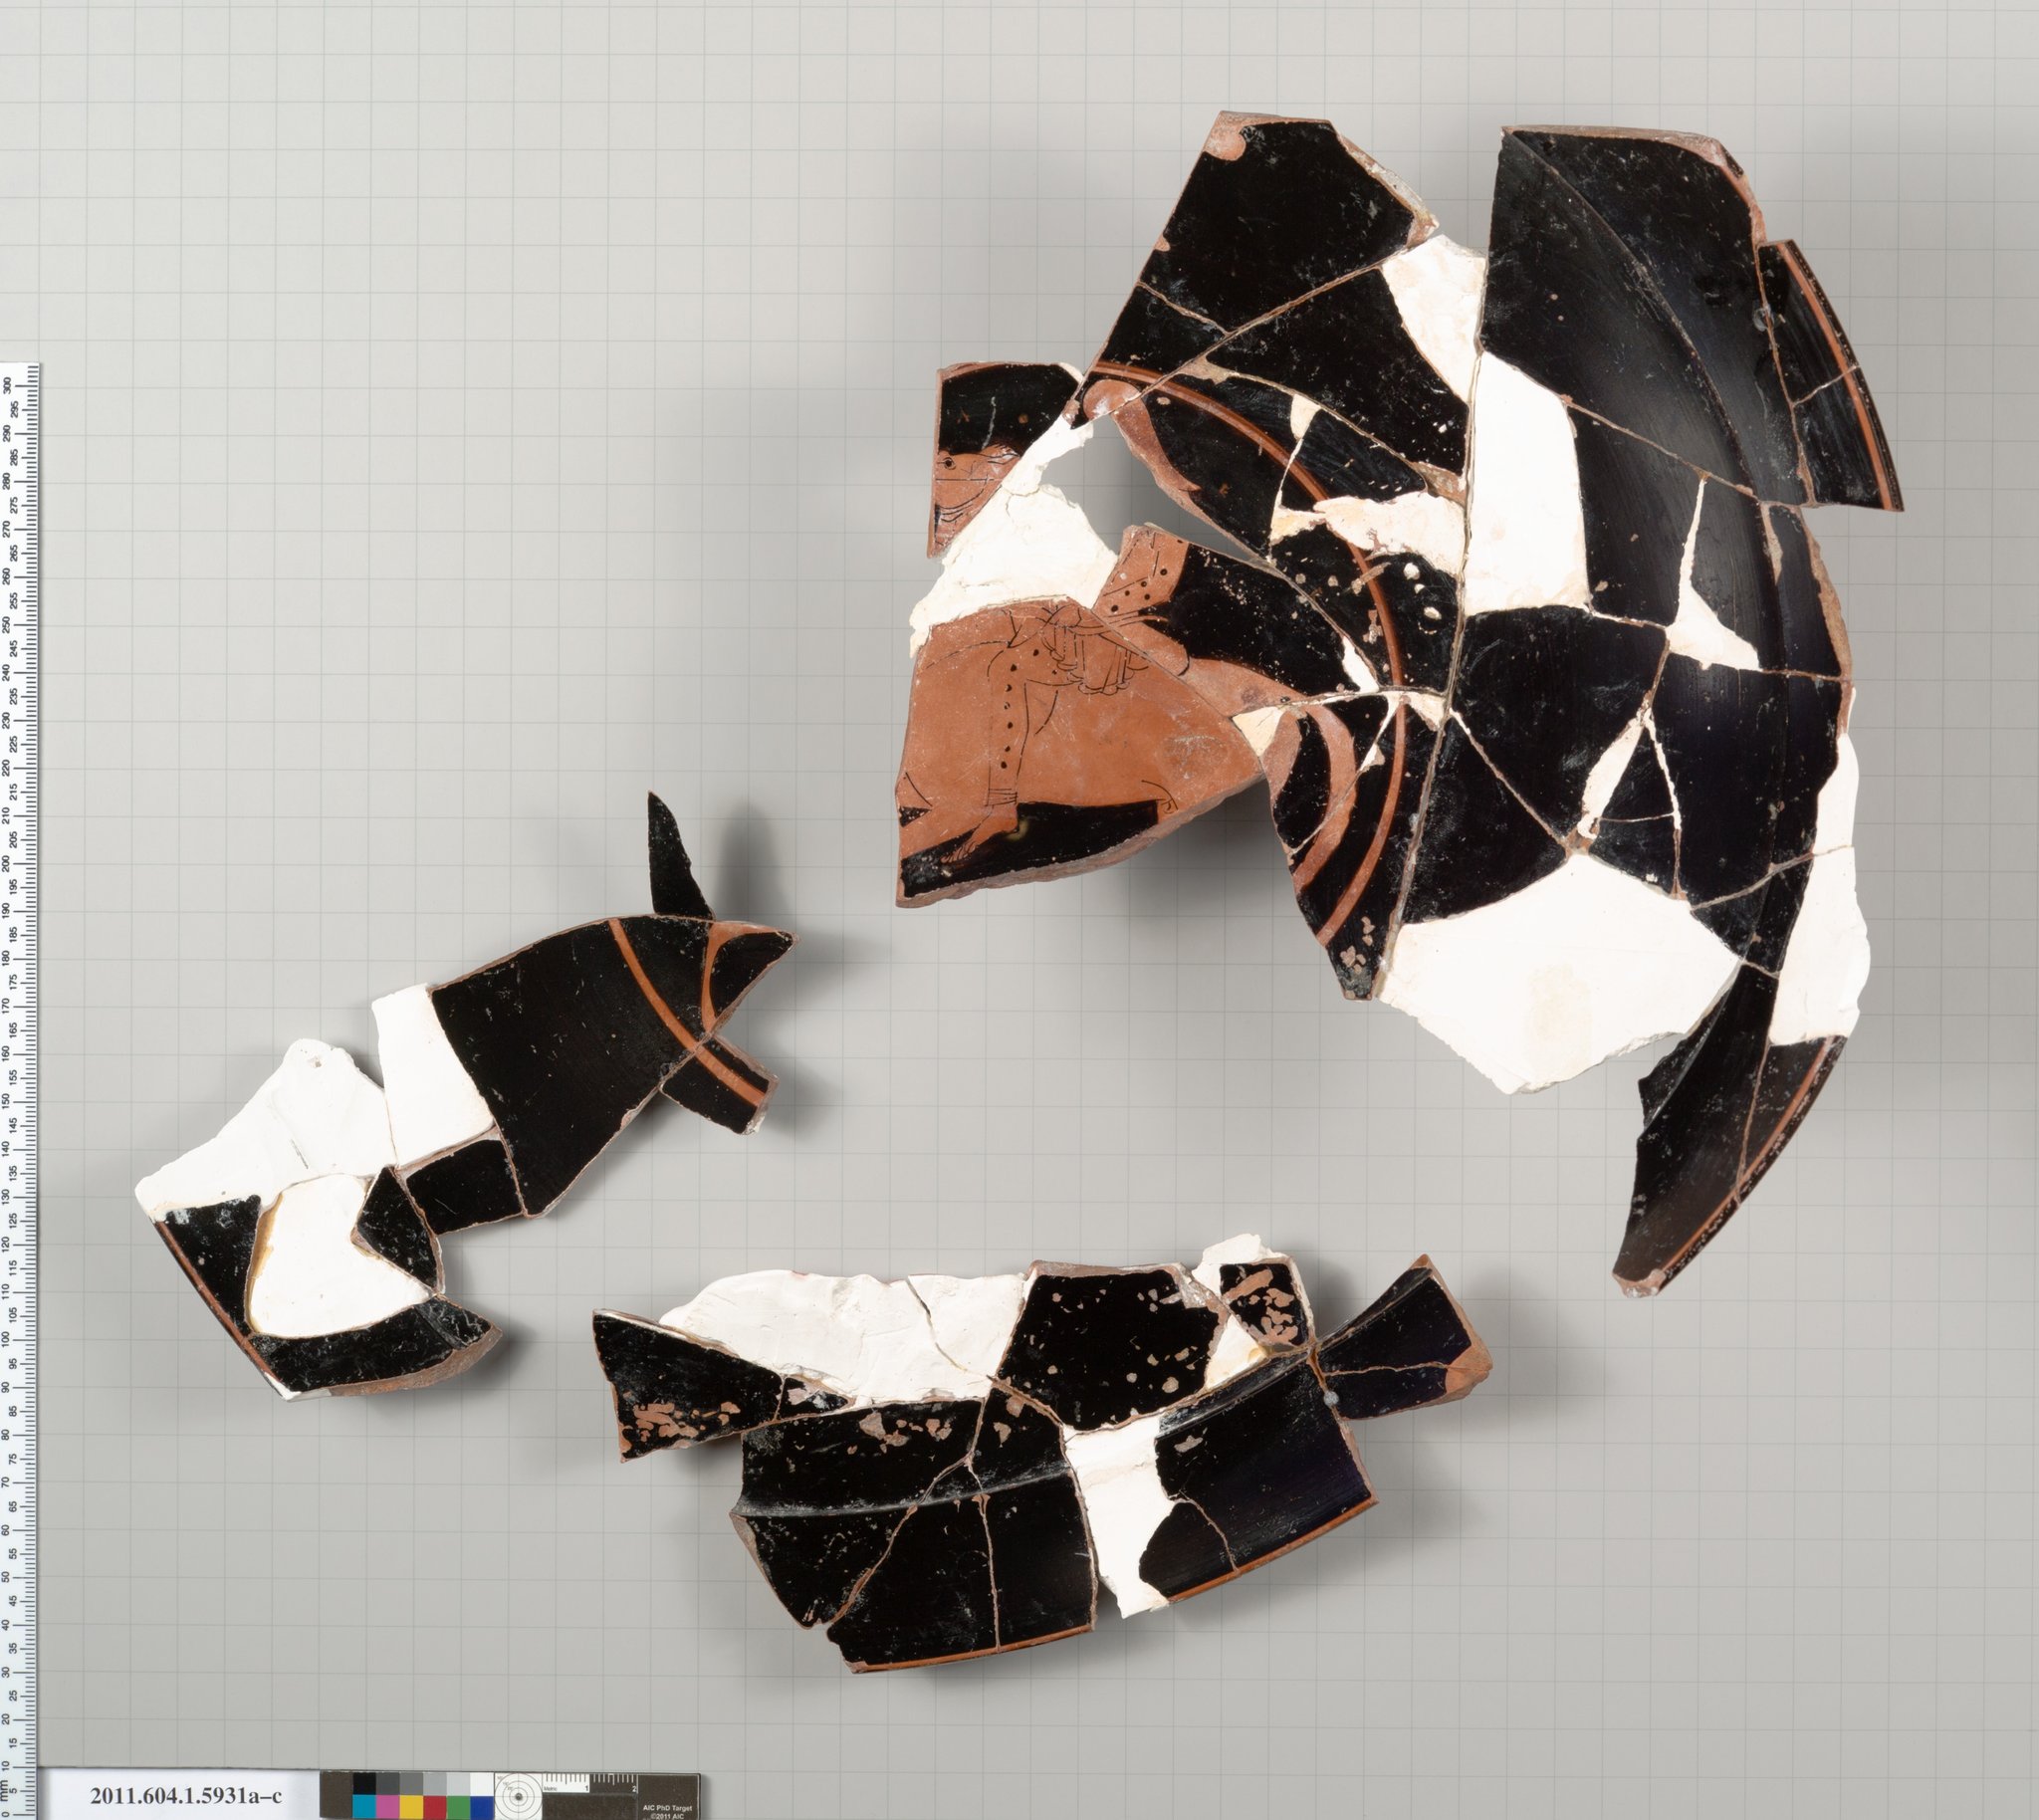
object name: kylix fragment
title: Terracotta fragments of a kylix (drinking cup)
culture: greek, attic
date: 520-510 BCE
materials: terracotta